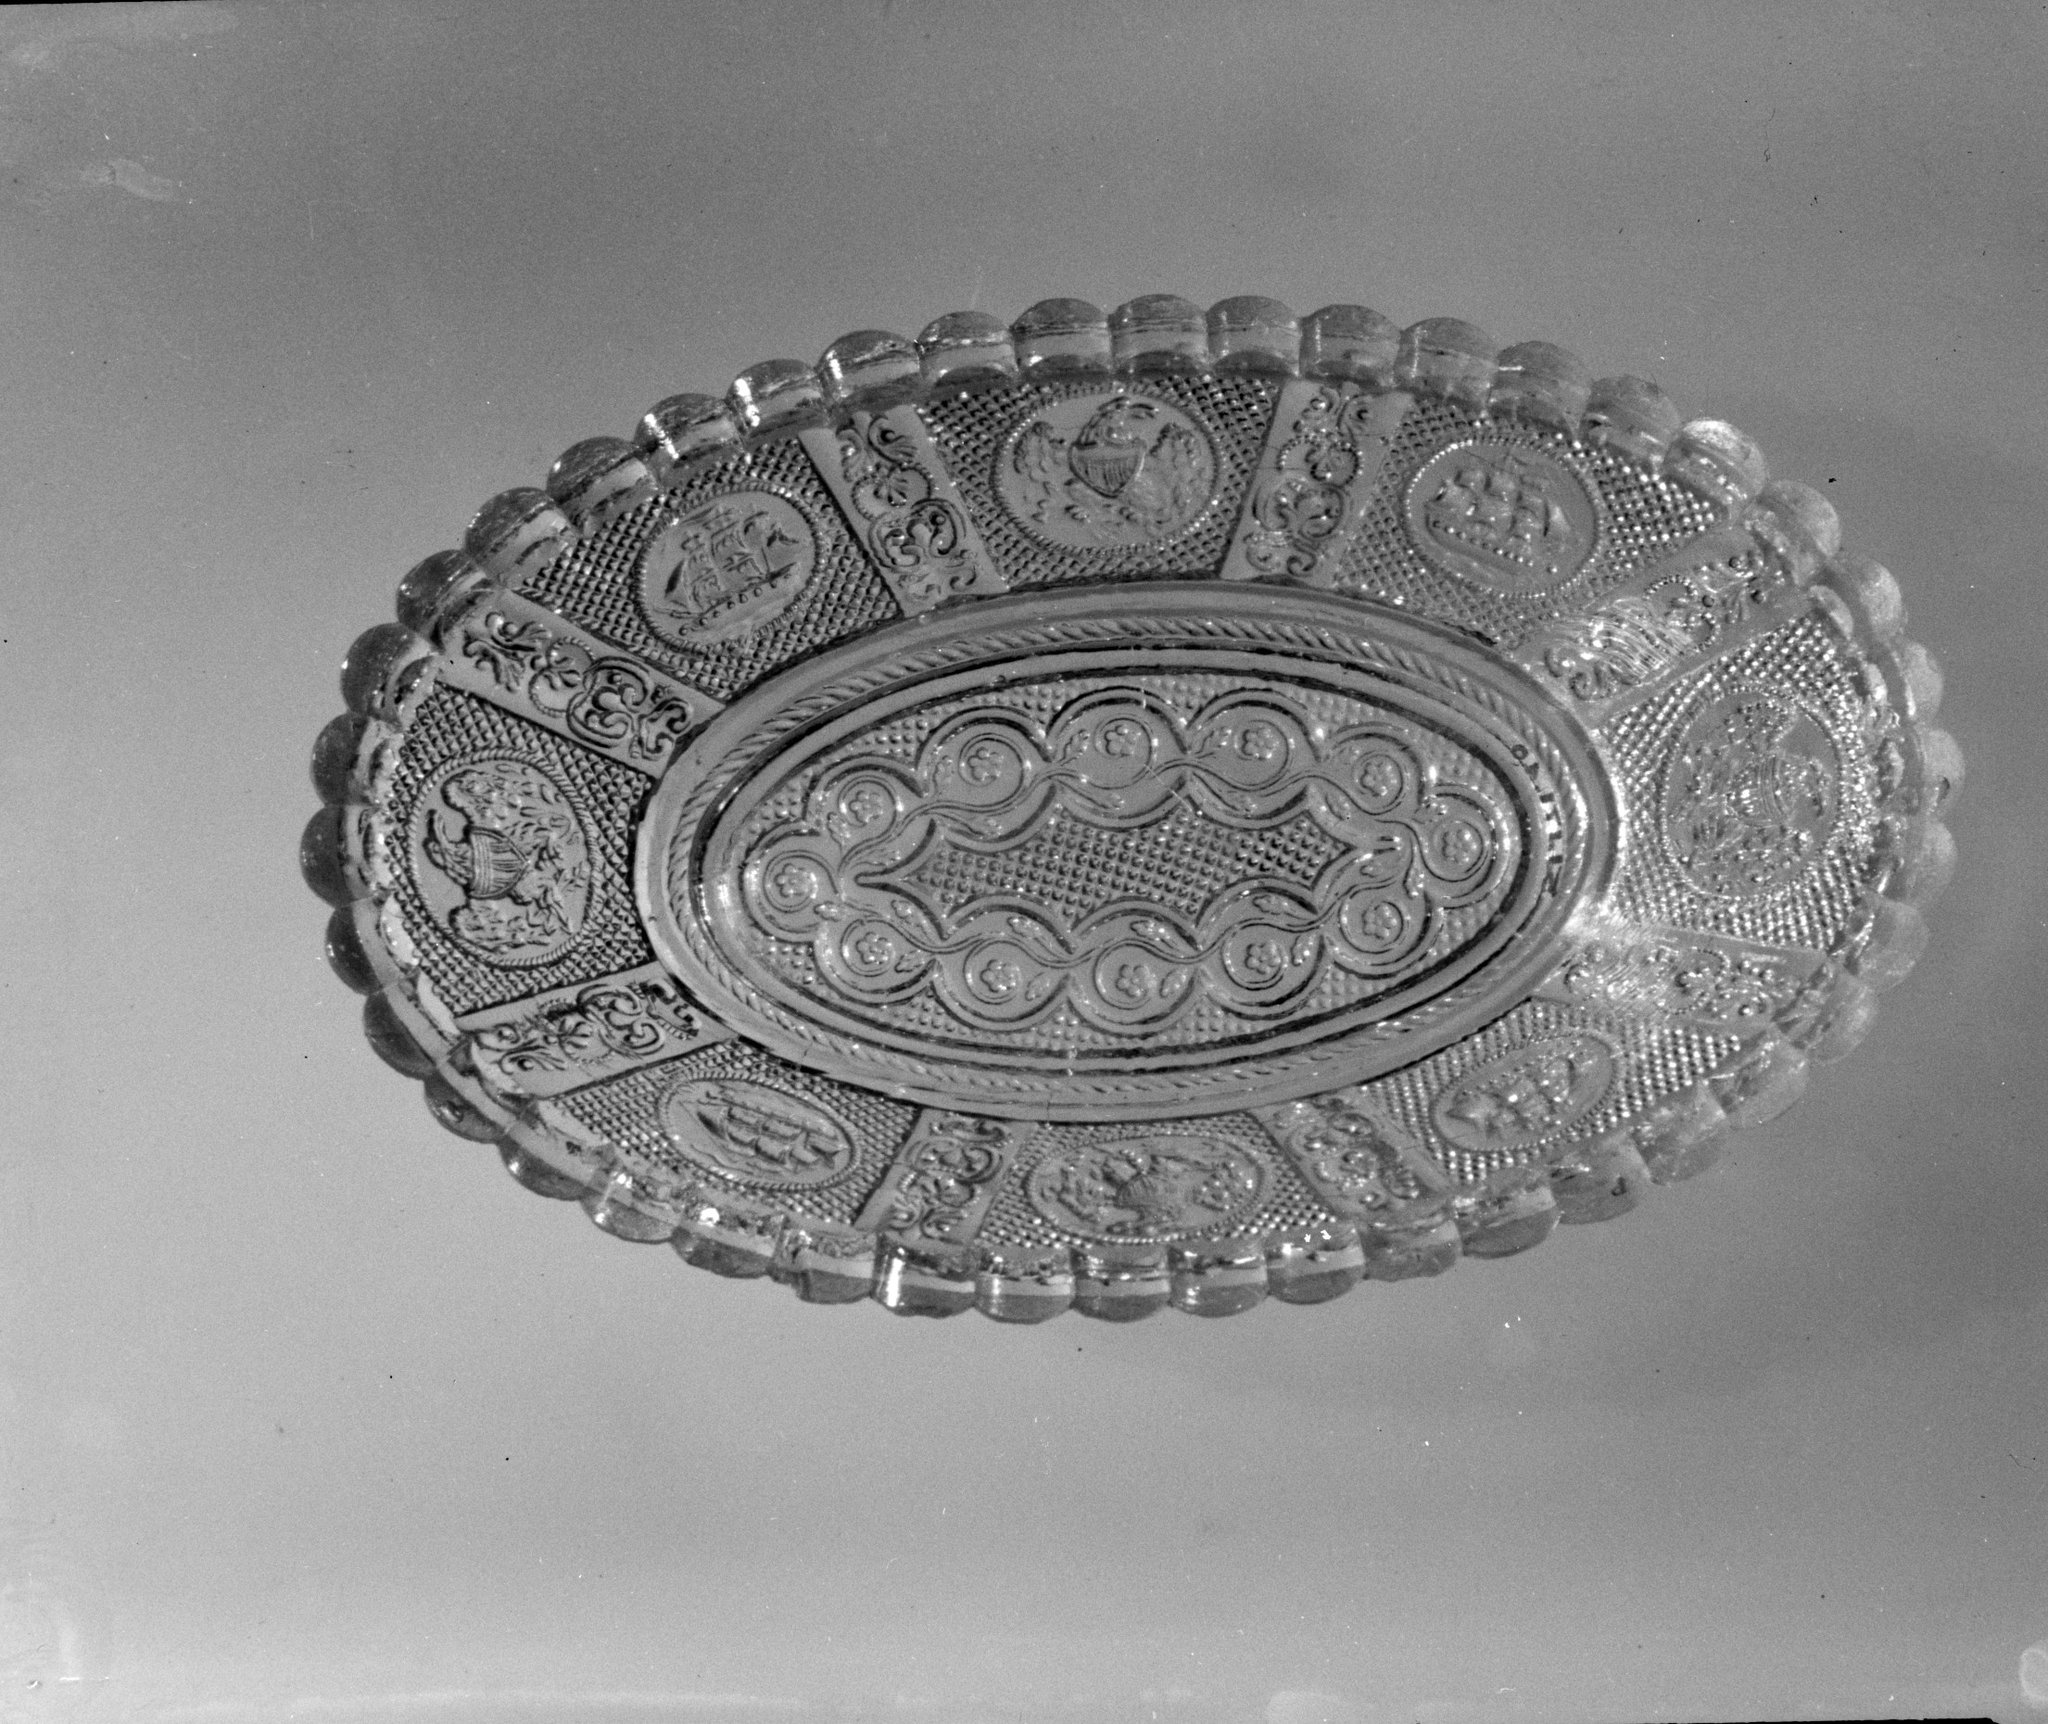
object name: dish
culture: american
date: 1830-1835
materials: glass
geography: united states